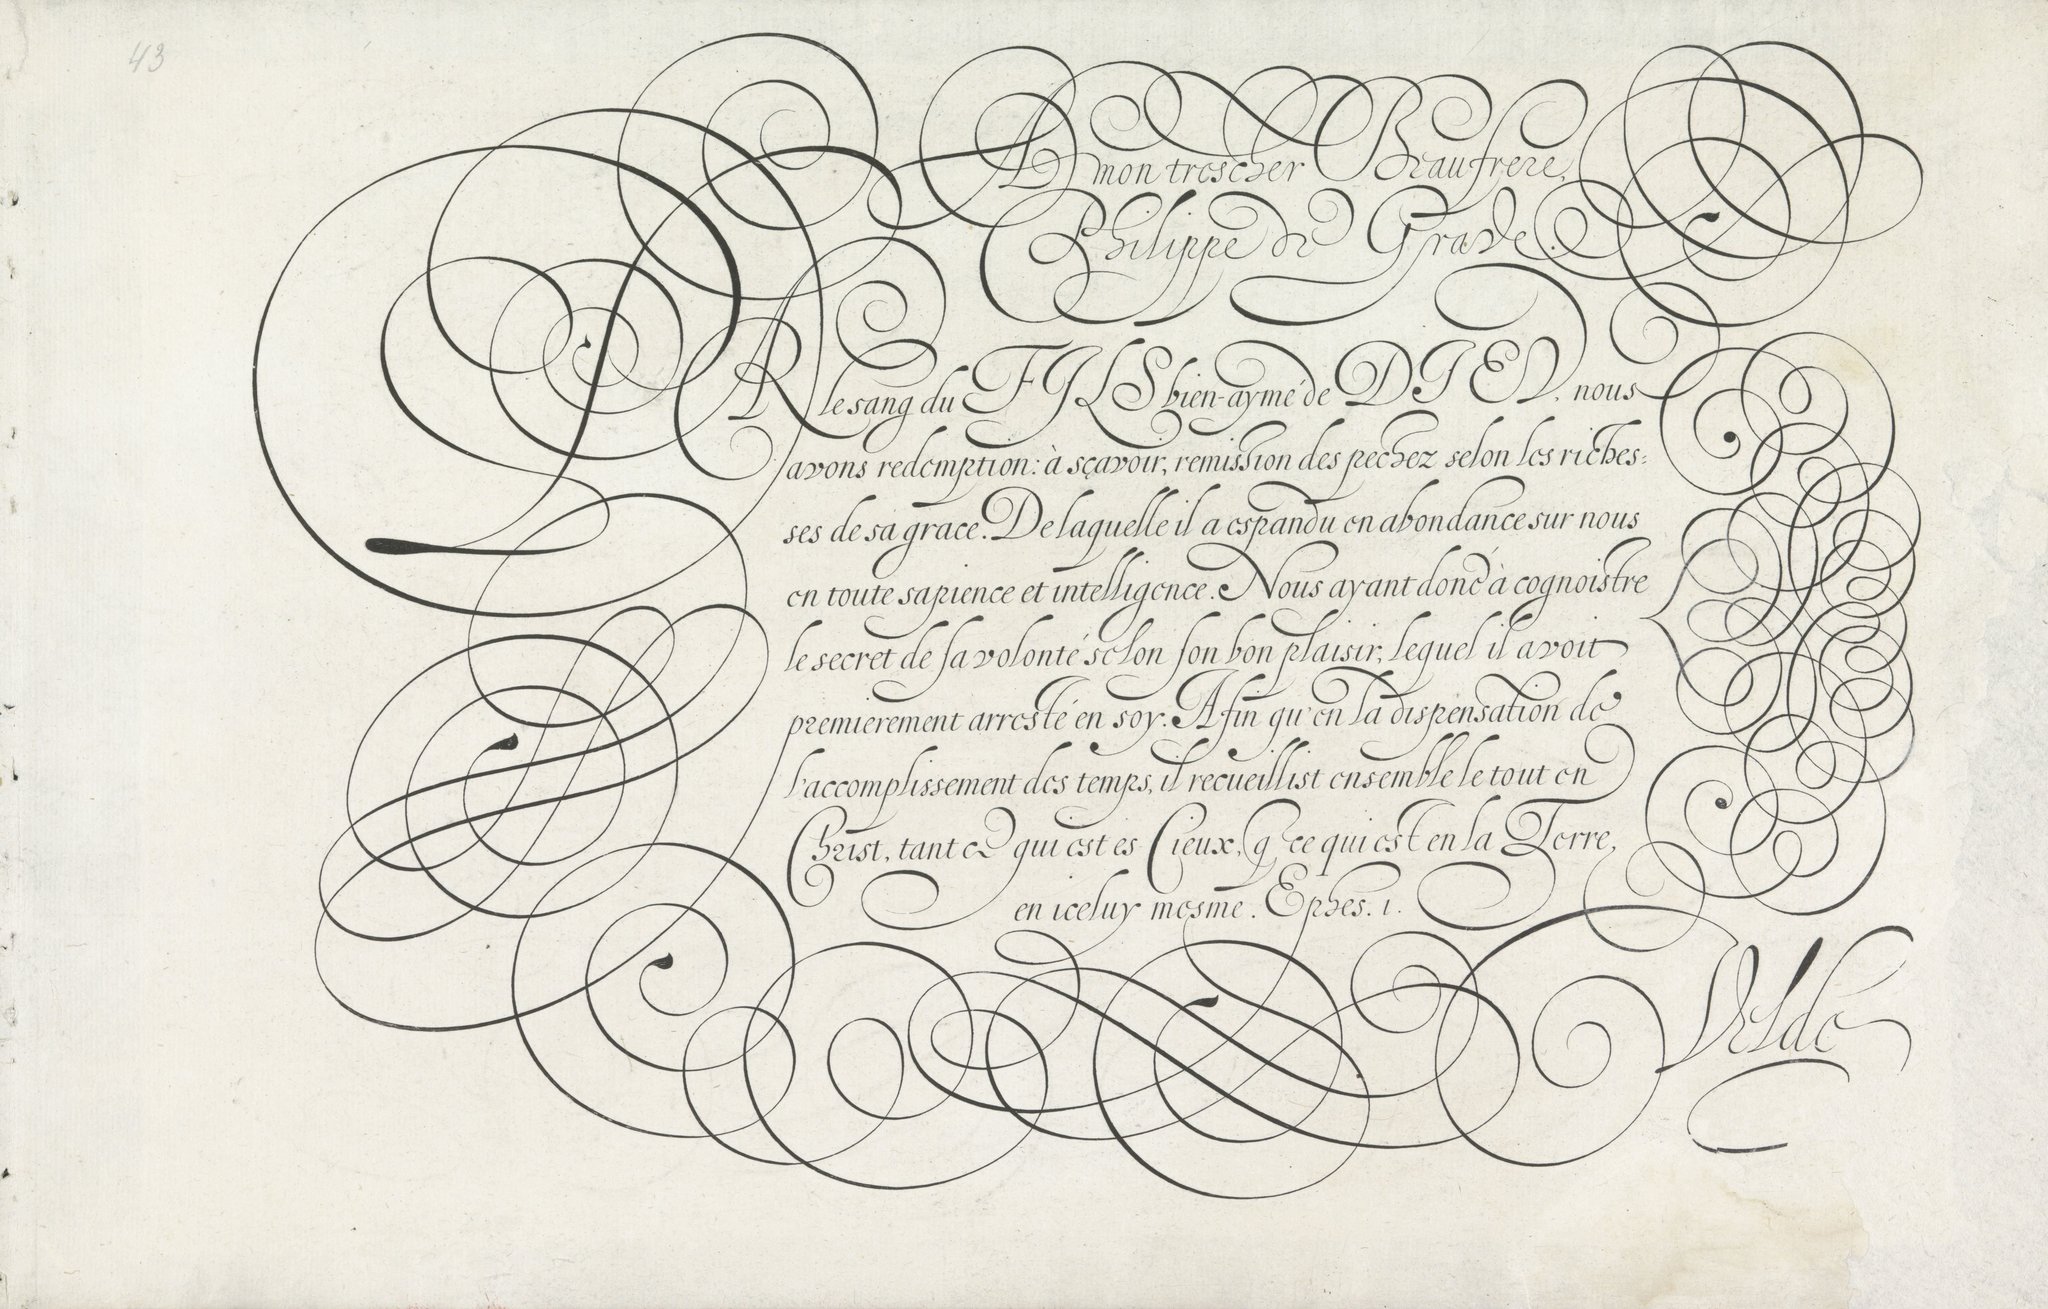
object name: ornament print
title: Schrijfvoorbeeld: A mon tres cher beaufrere (...)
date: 1605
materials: paper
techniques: engraving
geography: rotterdam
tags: calligraphy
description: Schrijfvoorbeeld met de aanhef: A mon tres cher beaufrere Philippe de Grave. Daaronder negen regels tekst in het Frans: Par le sang du fils ... De tekst is omlijst met krulwerk. De prent maakt deel uit van een album.